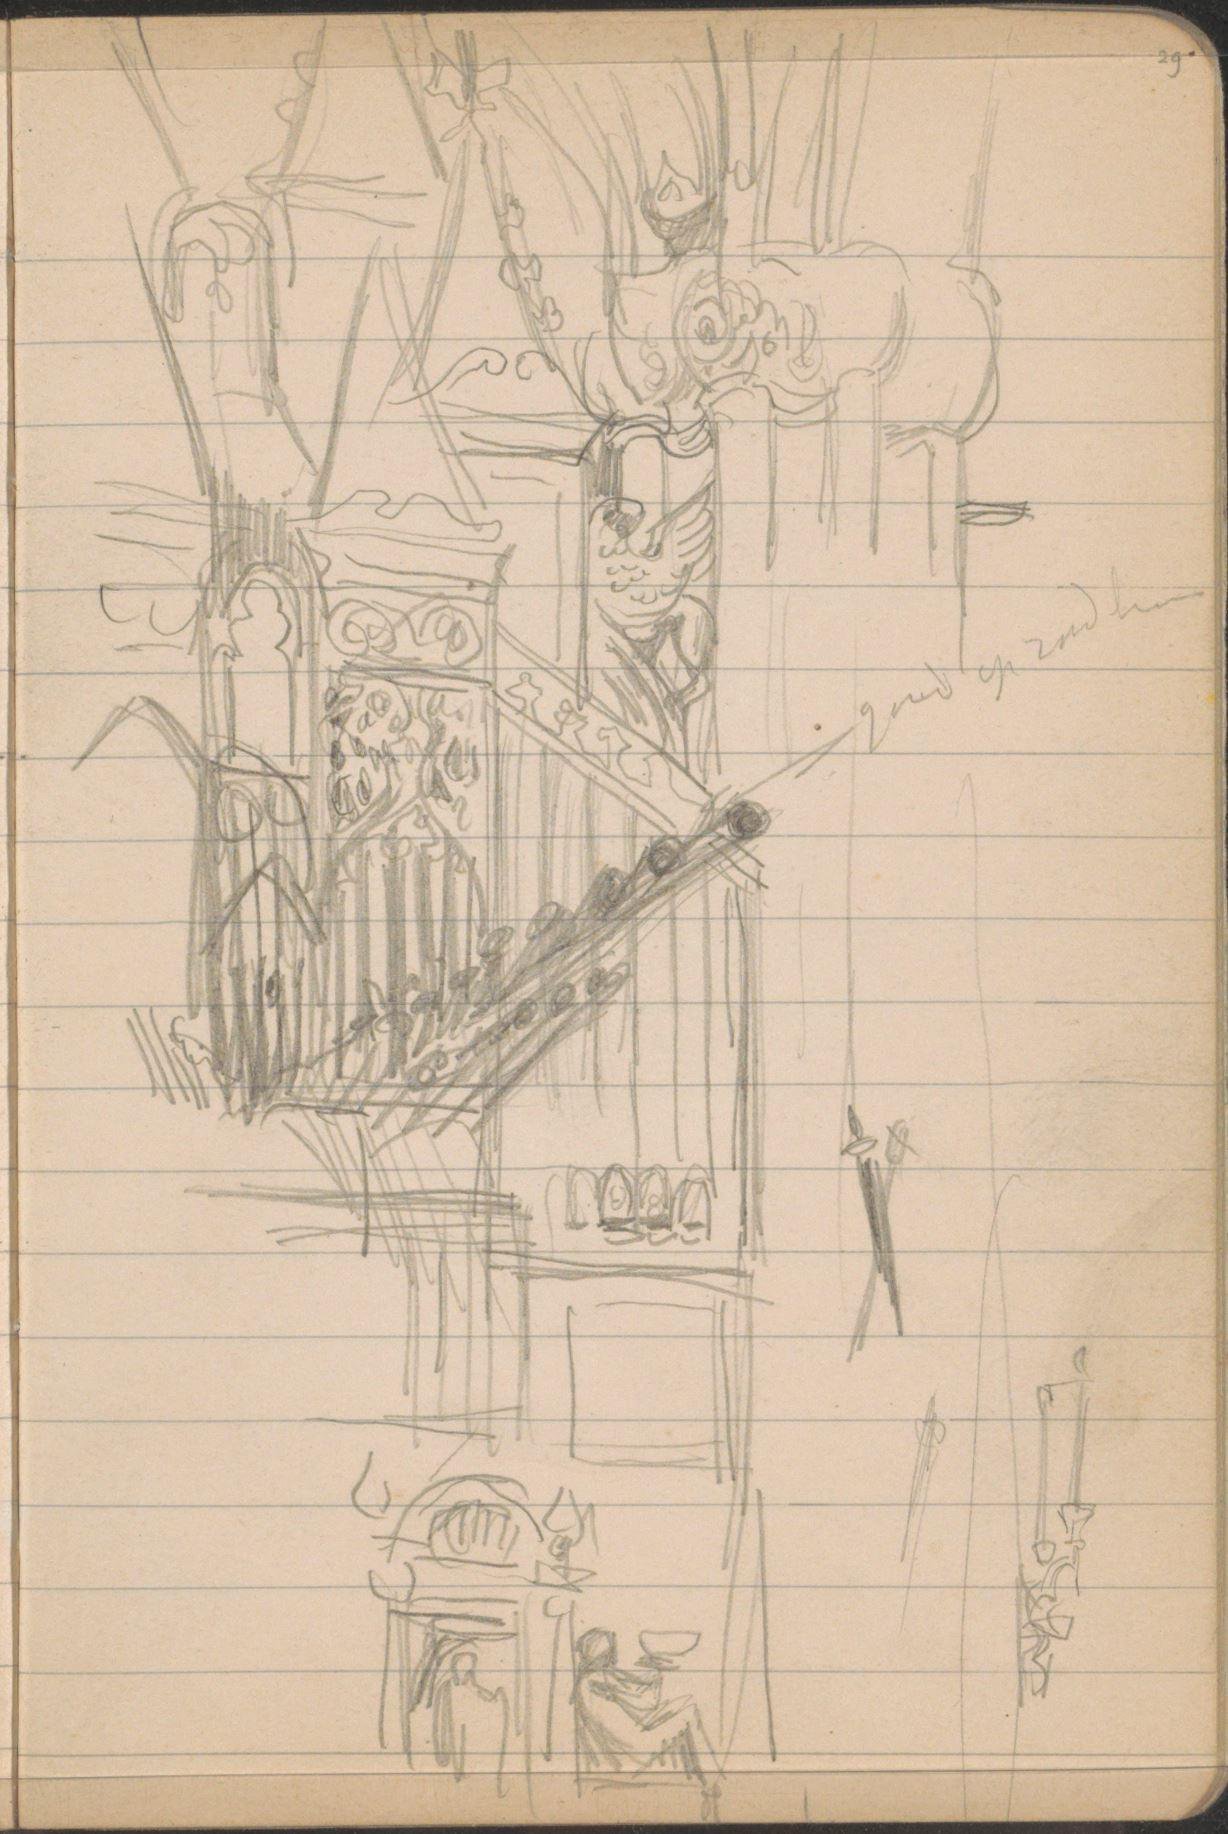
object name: sketchbook leaf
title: Interieur van de La Seo kathedraal in Zaragoza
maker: marius bauer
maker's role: draughtsman, print maker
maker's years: 1867-1932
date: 1902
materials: pencil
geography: zaragoza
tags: interior of church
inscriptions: kleurnotitie, handgeschreven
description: Pagina 29 uit een schetsboek met 50 bladen.